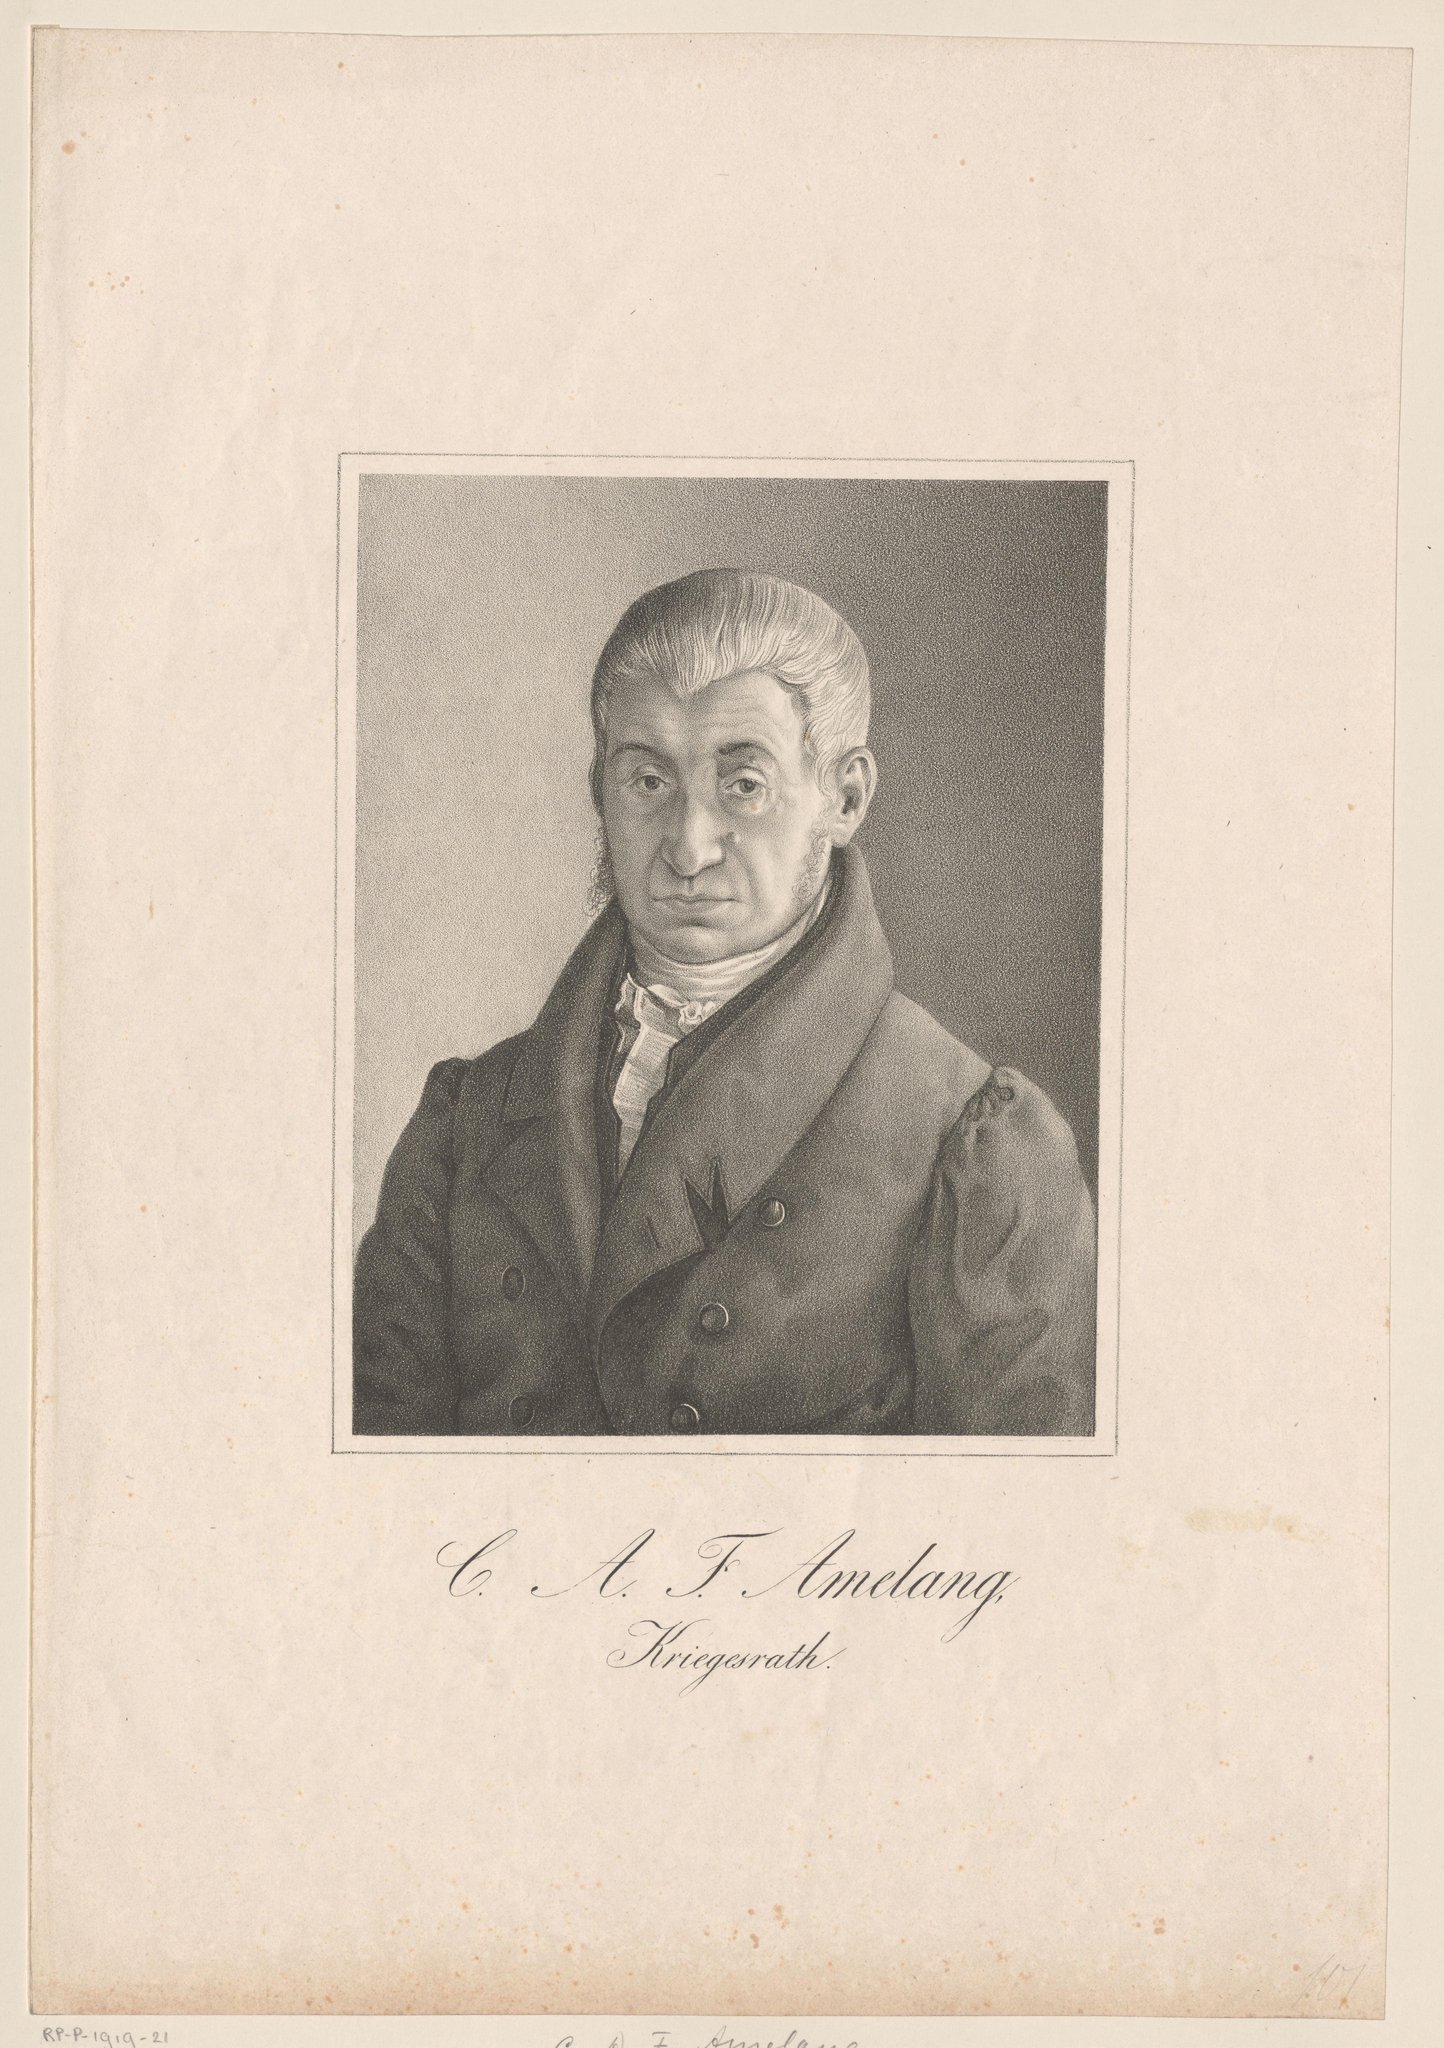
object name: print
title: Portret van Carl August Friedrich Amelang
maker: Anonymous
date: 1795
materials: paper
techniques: lithograph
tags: historical persons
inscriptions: collector's mark: Lugt 2228